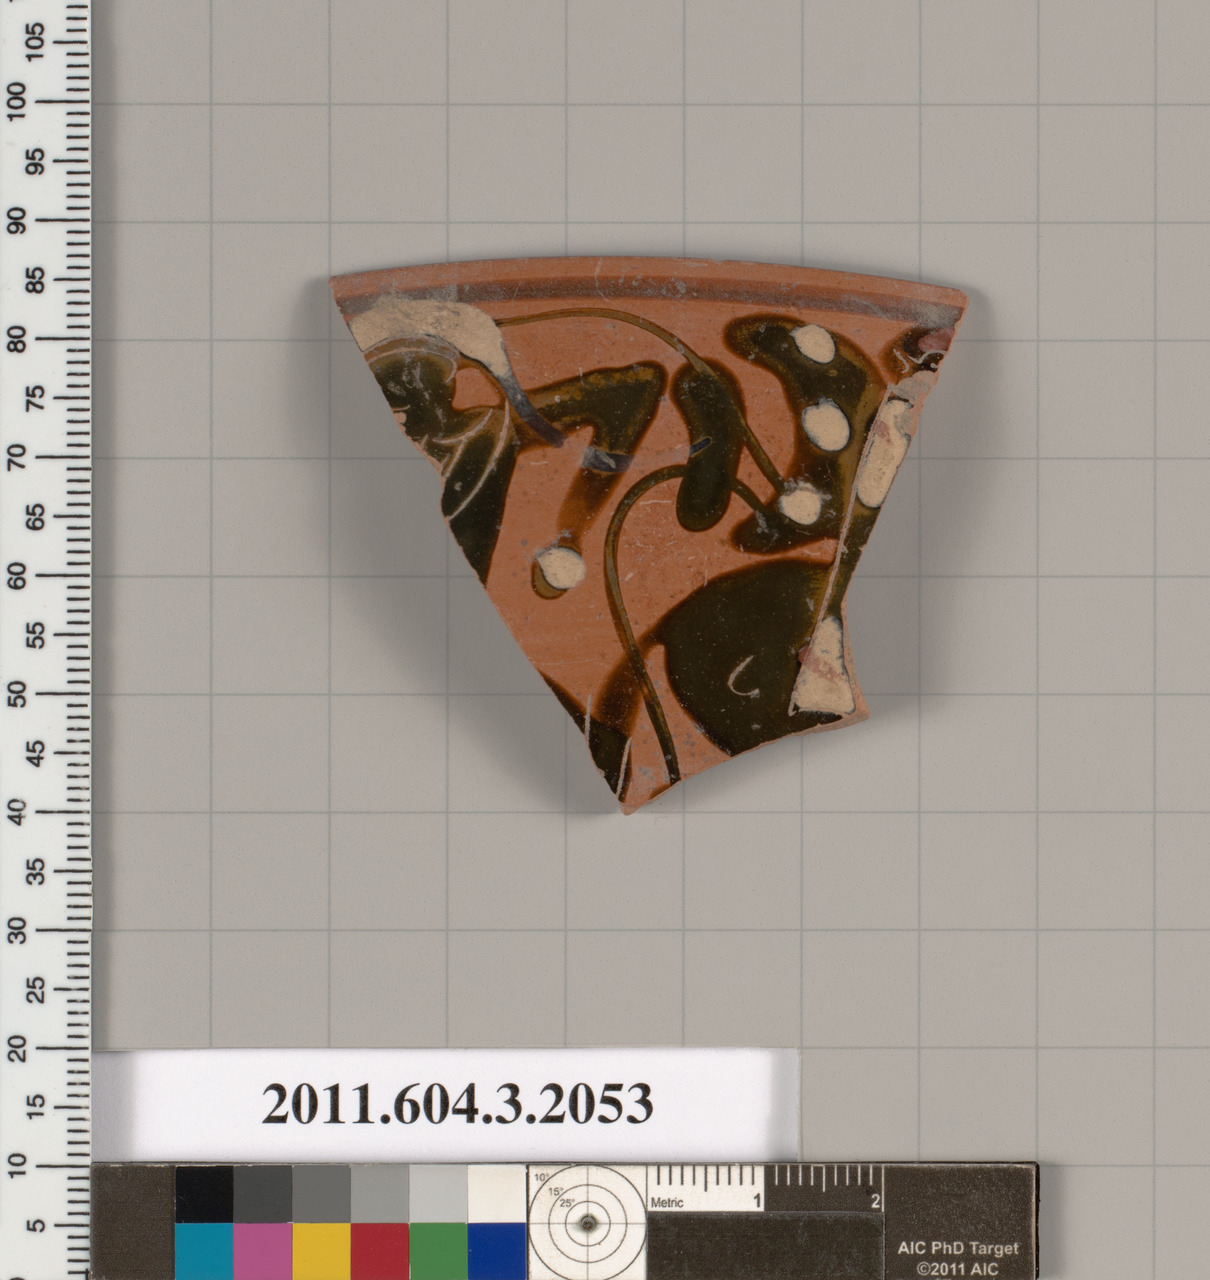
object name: kylix fragment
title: Terracotta rim fragment of a kylix (drinking cup)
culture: greek, attic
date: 500-468 BCE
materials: terracotta